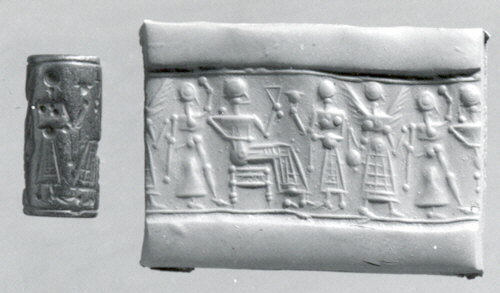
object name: cylinder seal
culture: cypriot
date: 1500-1201 BCE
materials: stone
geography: cyprus